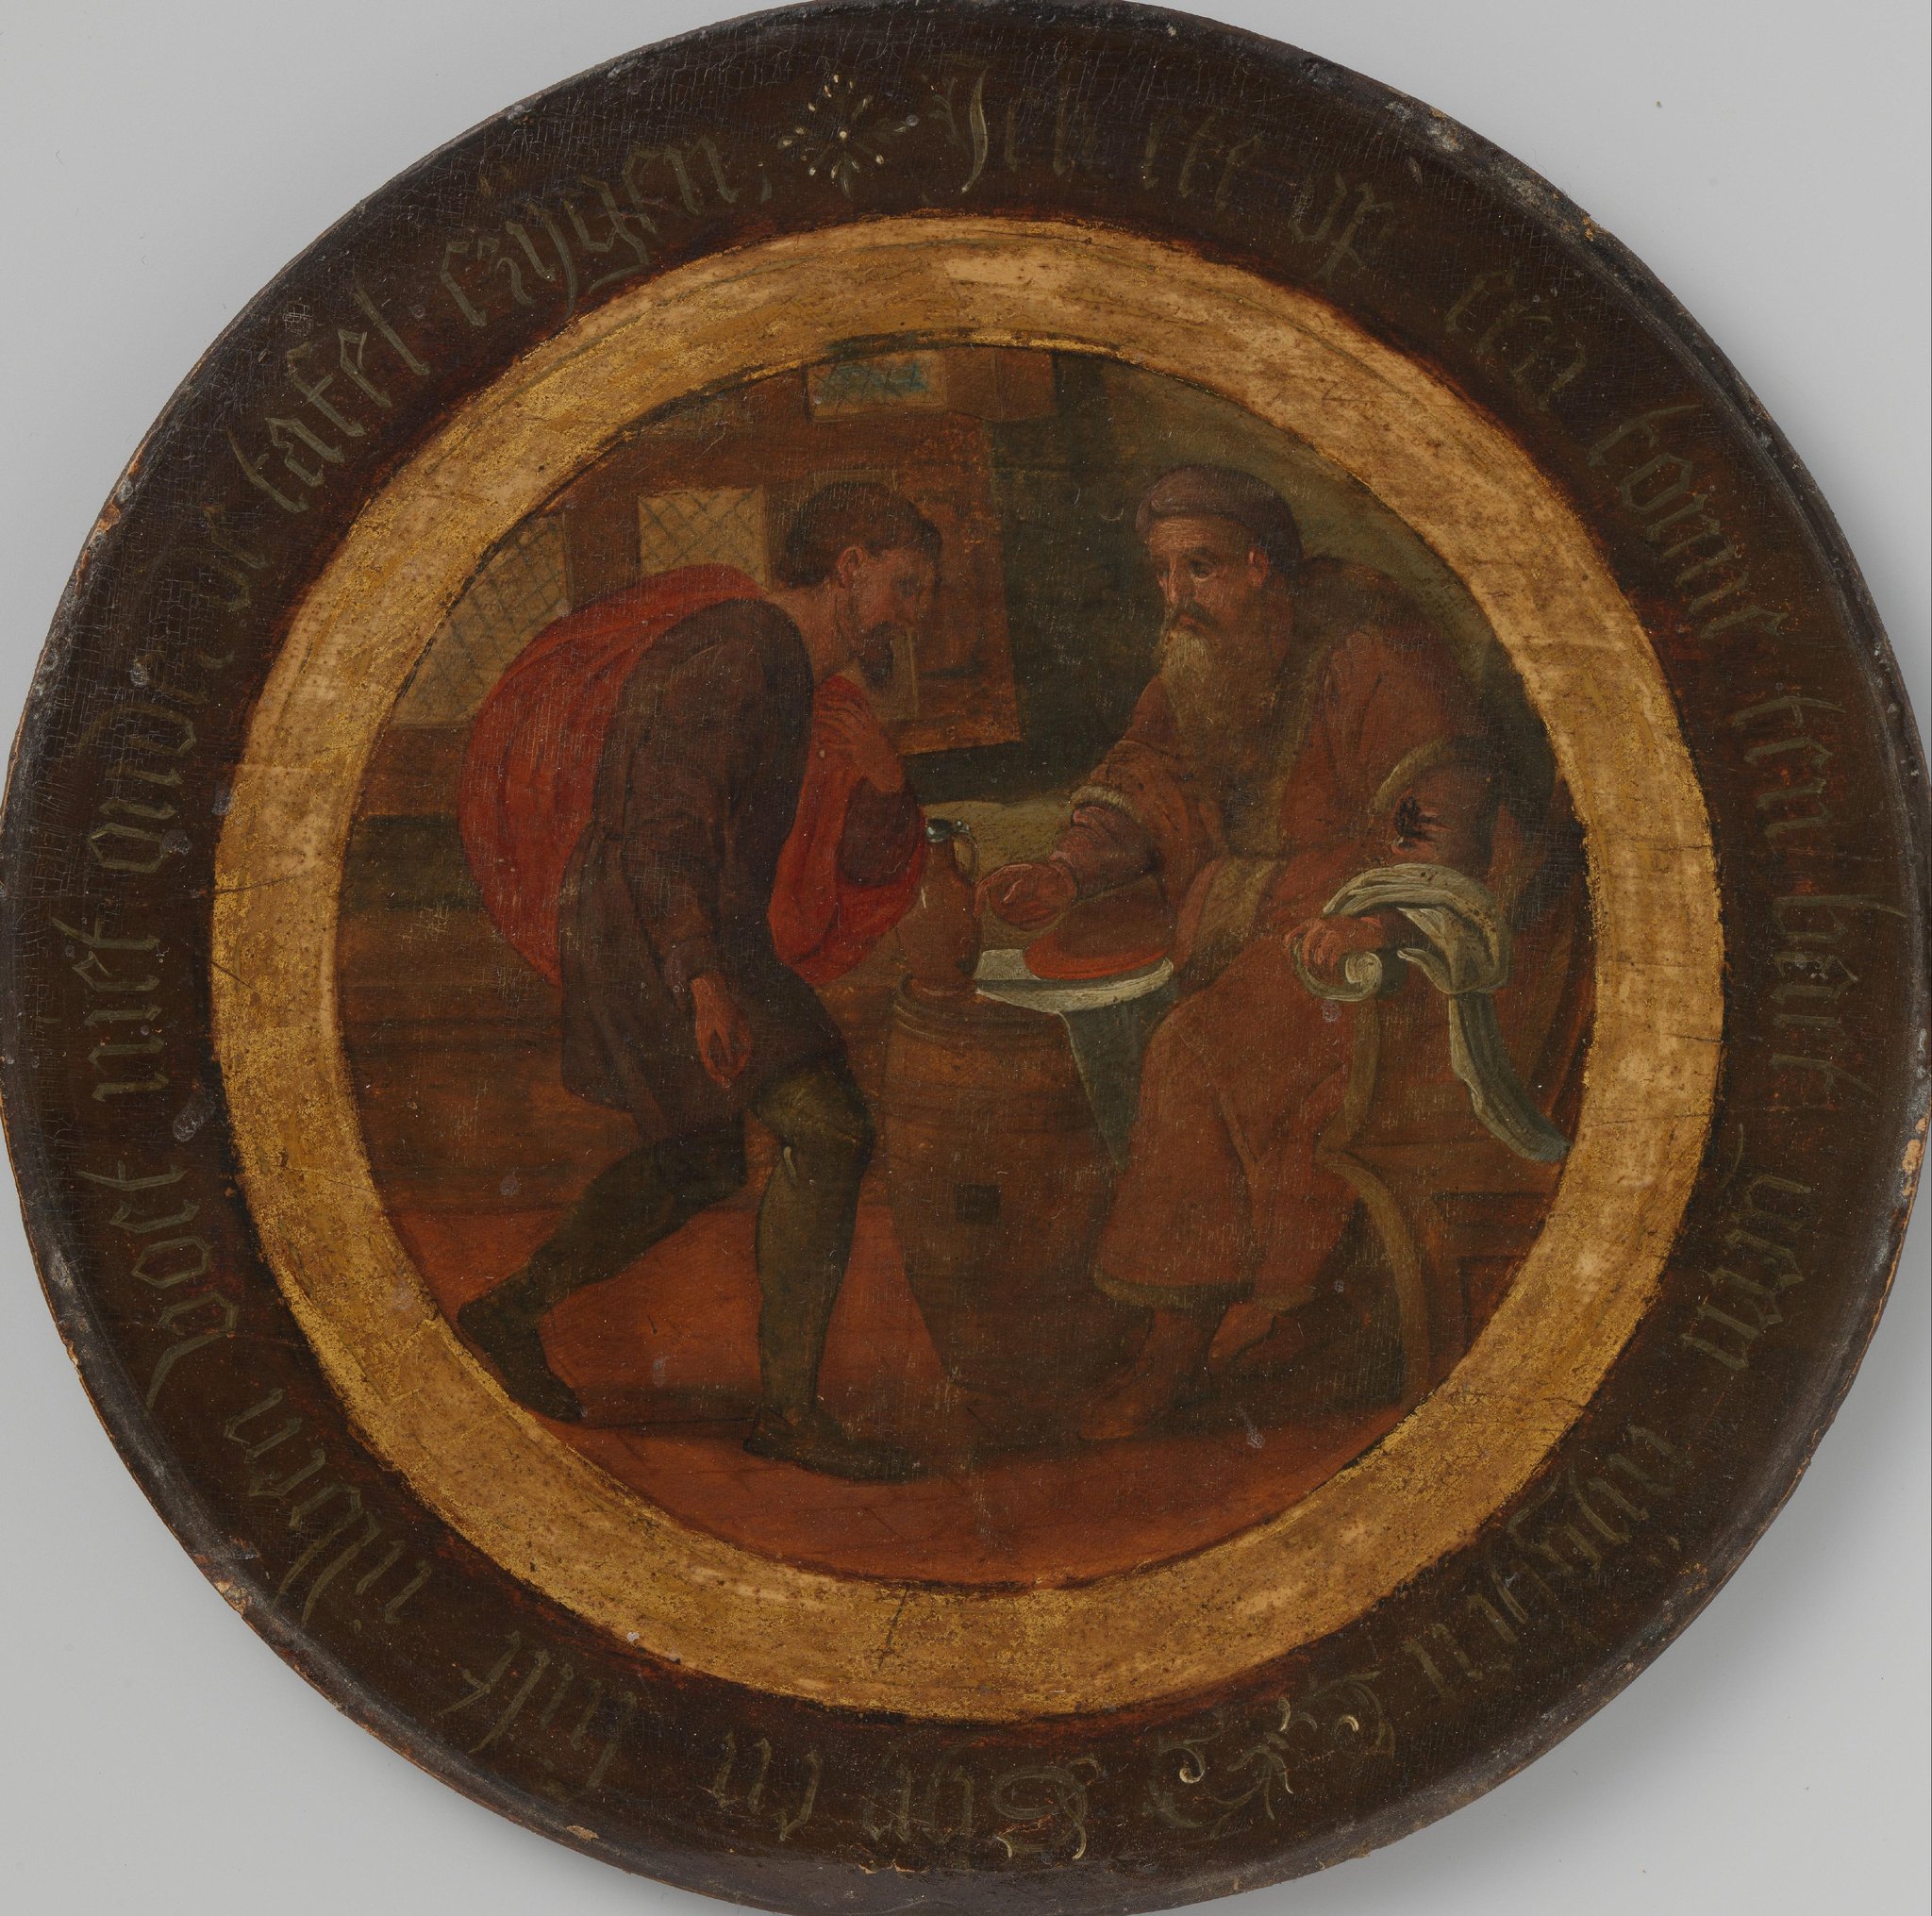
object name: painting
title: Allegory of the Cooperage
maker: Anonymous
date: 1580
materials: oil, panel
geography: southern netherlands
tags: eating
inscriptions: inscription: ‘Ick ete op een tonne 't en baet geen nijghen. Ghij en sult uwen voet niet onder de tafel crijgen.’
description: Allegorie op de kuiperij. Een man zit achter een ton waarop een kruik en brood staan en gebaart naar een man die voor hem staat en buigt. Om de ronde voorstelling staat een vers. Zie ook nrs. SK-A-4466 en SK-A-4467.